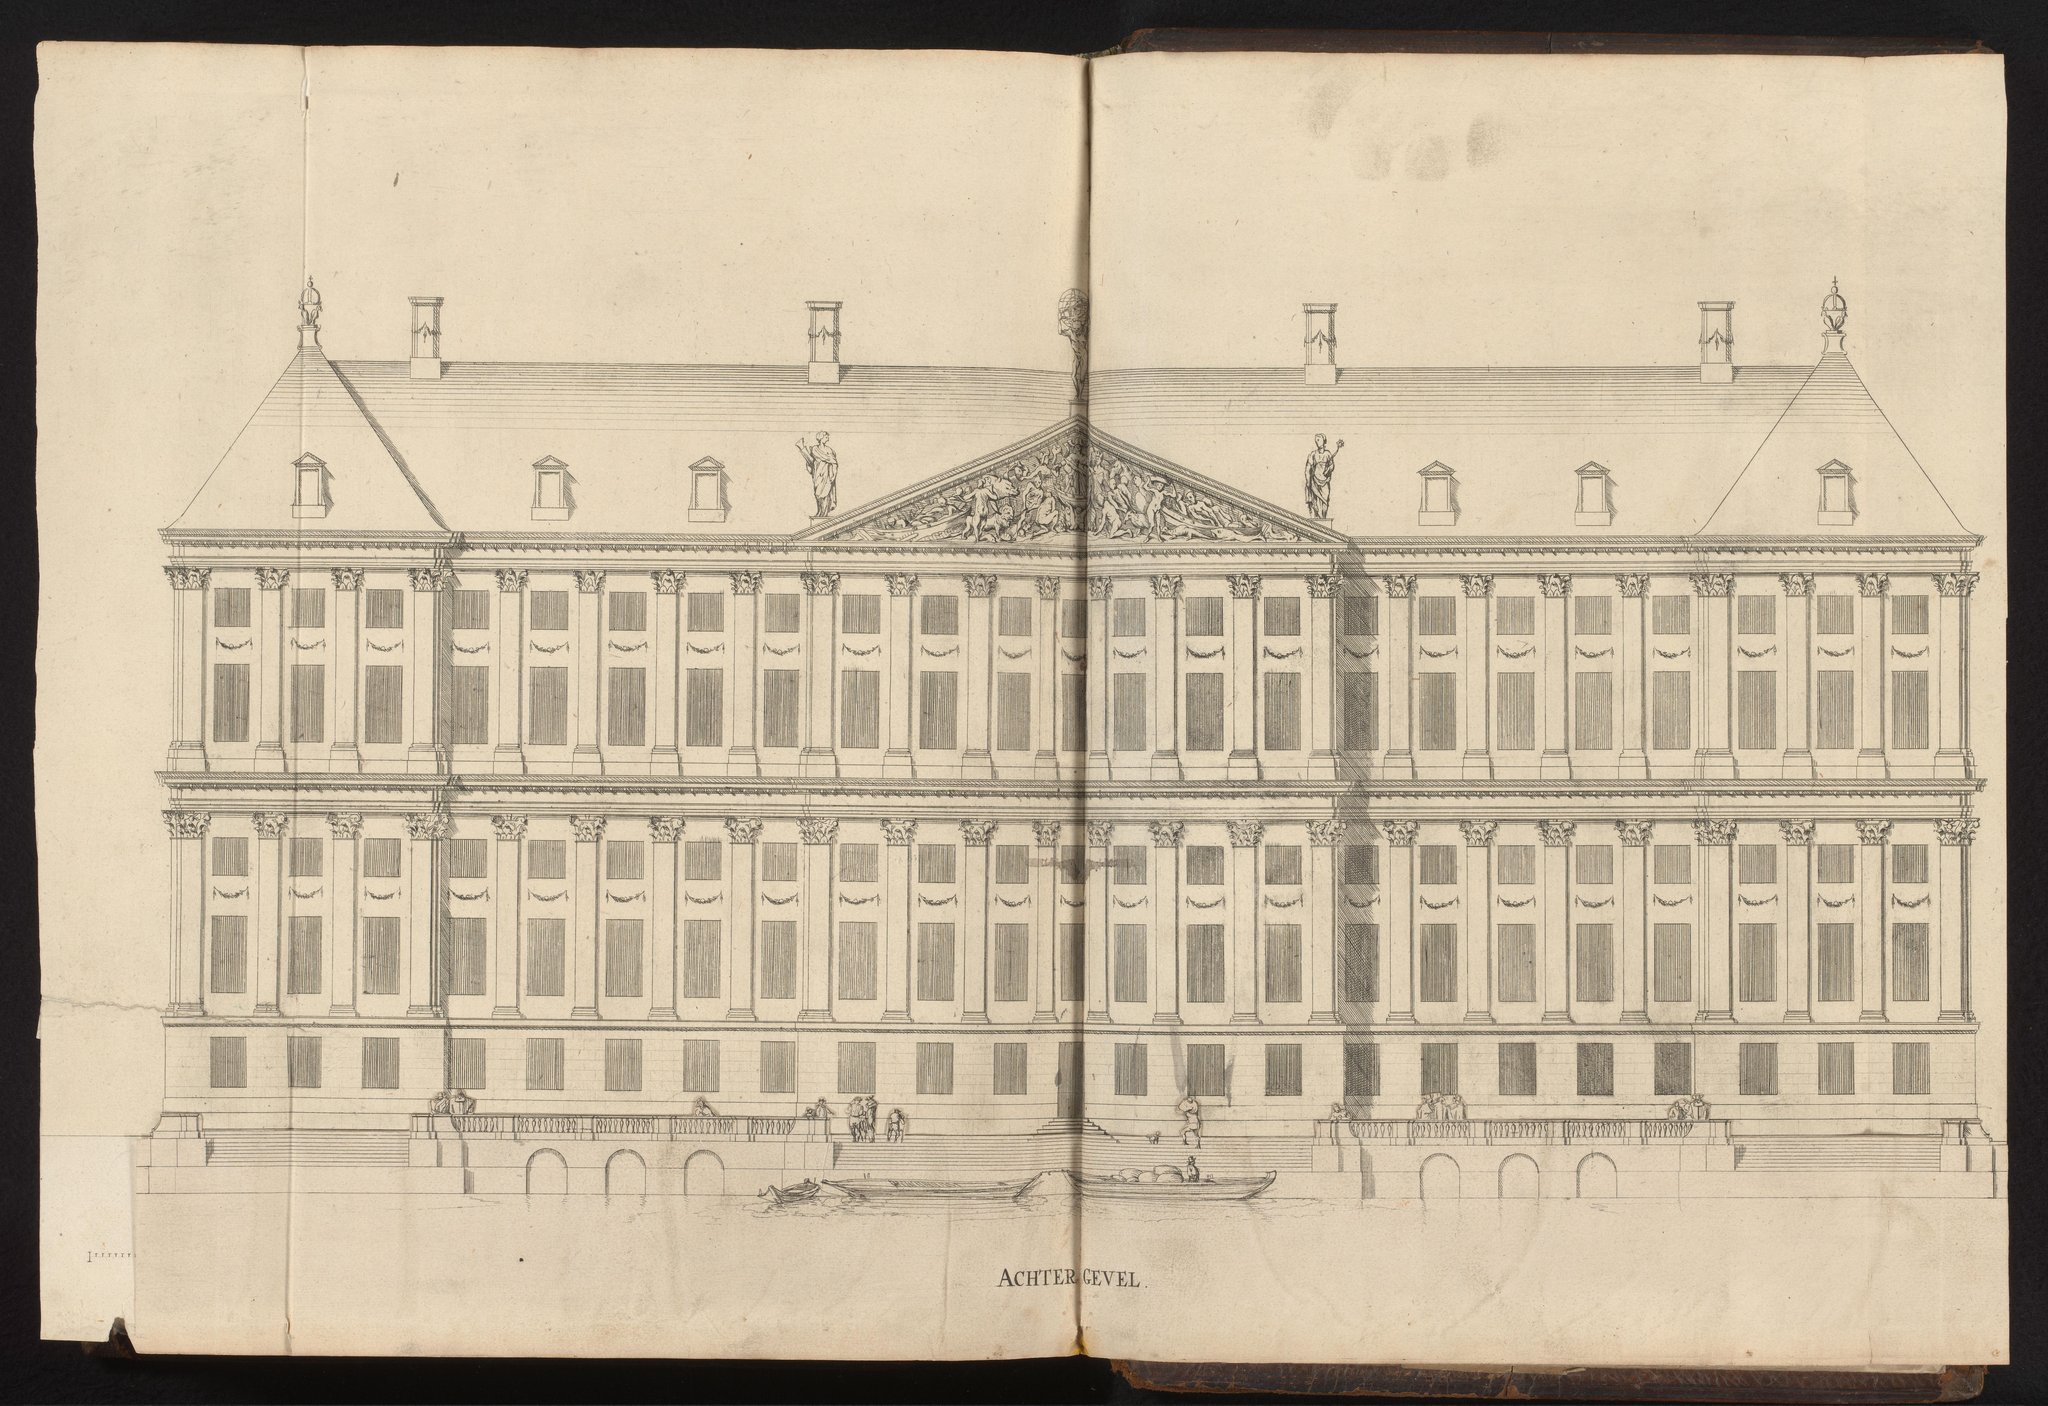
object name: print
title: Achtergevel (westzijde) van het Stadhuis op de Dam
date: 1650-1675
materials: paper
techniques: etching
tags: townhall, exterior ~ representation of a building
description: Onderaan is een omklapbare strook over de prent heen geplakt, met daarop een kade, bootjes en een aantal mensen. Achter de strook bevindt zich een schaalaanduiding. Prent maakt deel uit van een convoluut.